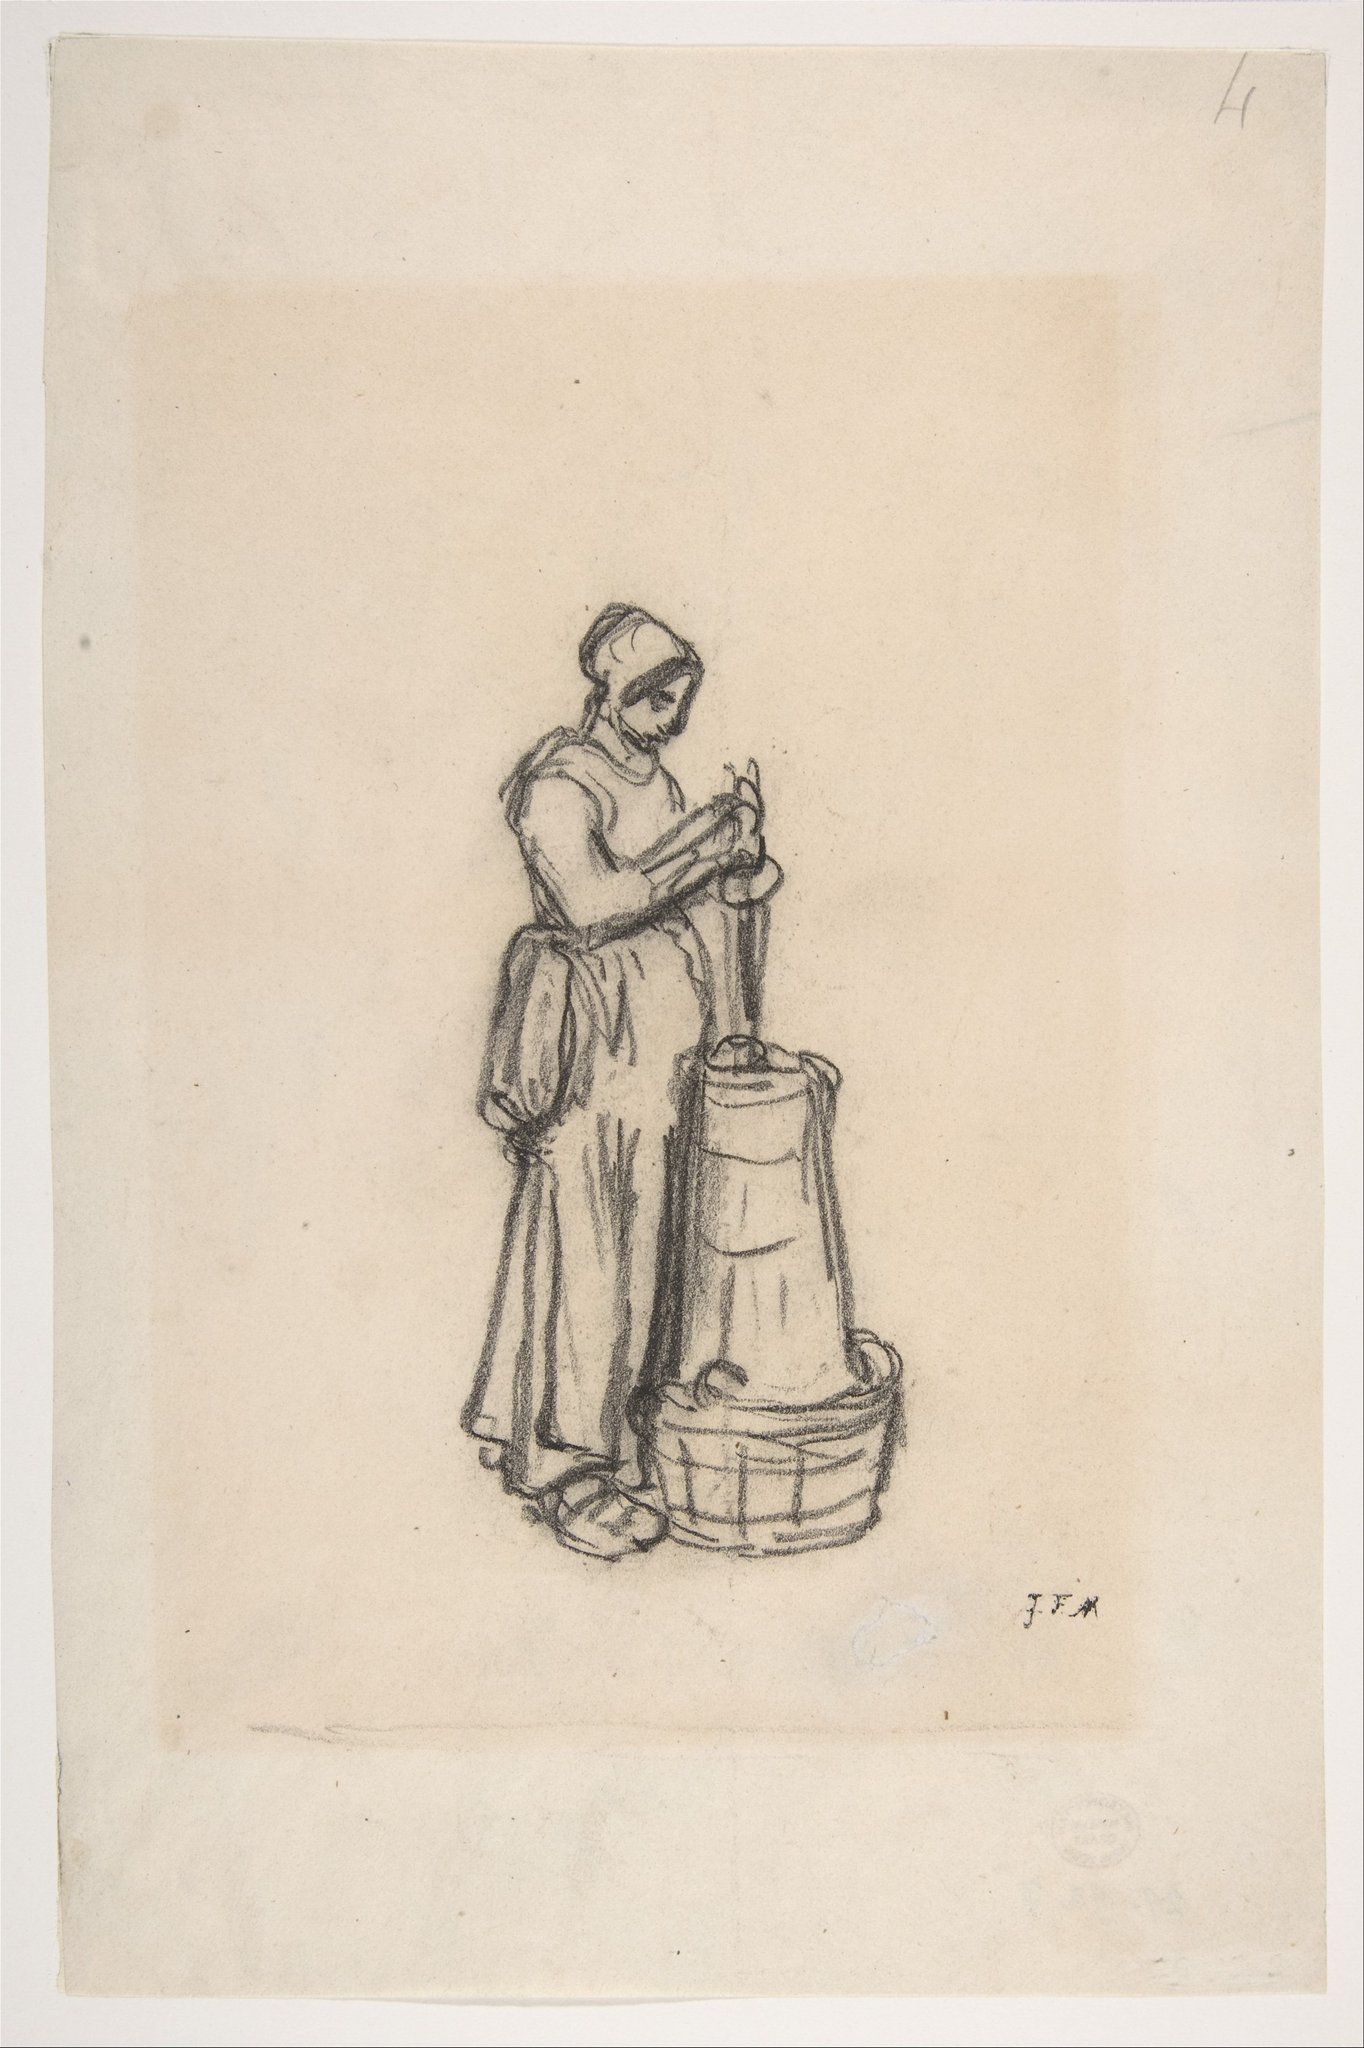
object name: drawing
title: Woman with a Churn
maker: jean-françois millet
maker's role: artist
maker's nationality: french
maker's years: 1814-1875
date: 1854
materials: crayon, paper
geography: france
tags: women